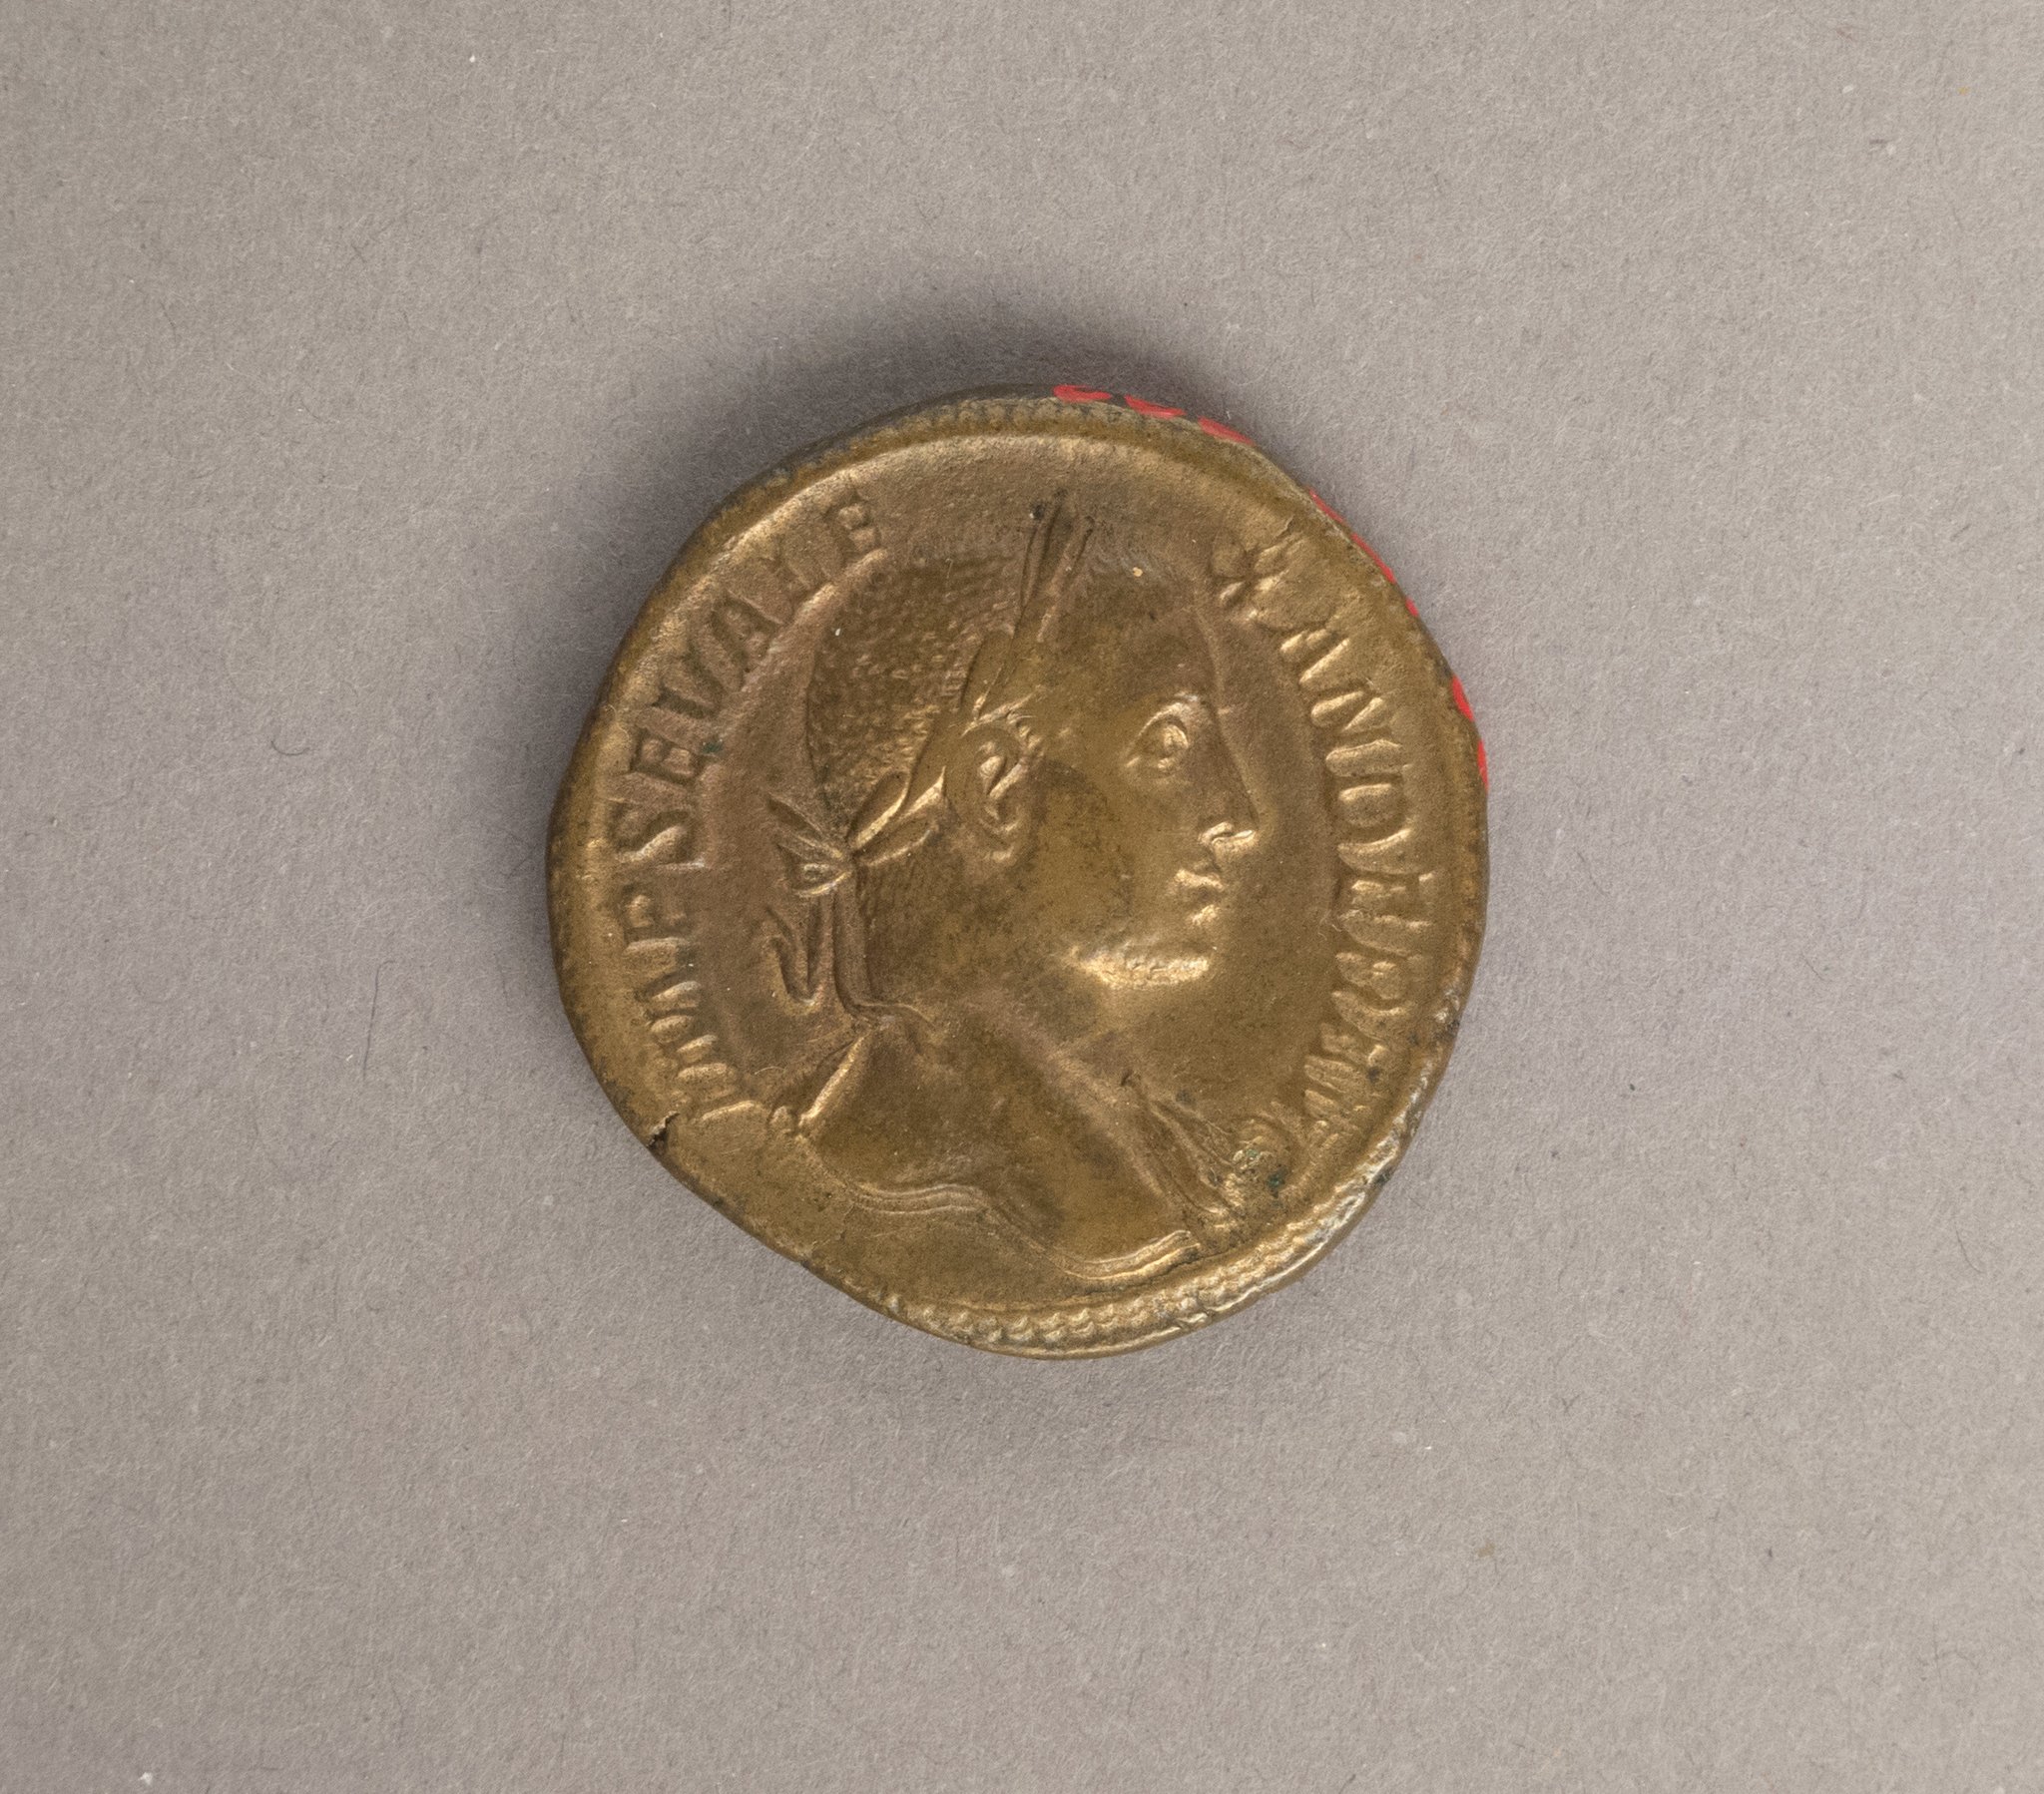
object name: sestertius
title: Bronze sestertius of Alexander Severus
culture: roman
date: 222-231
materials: bronze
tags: men,profiles,jupiter